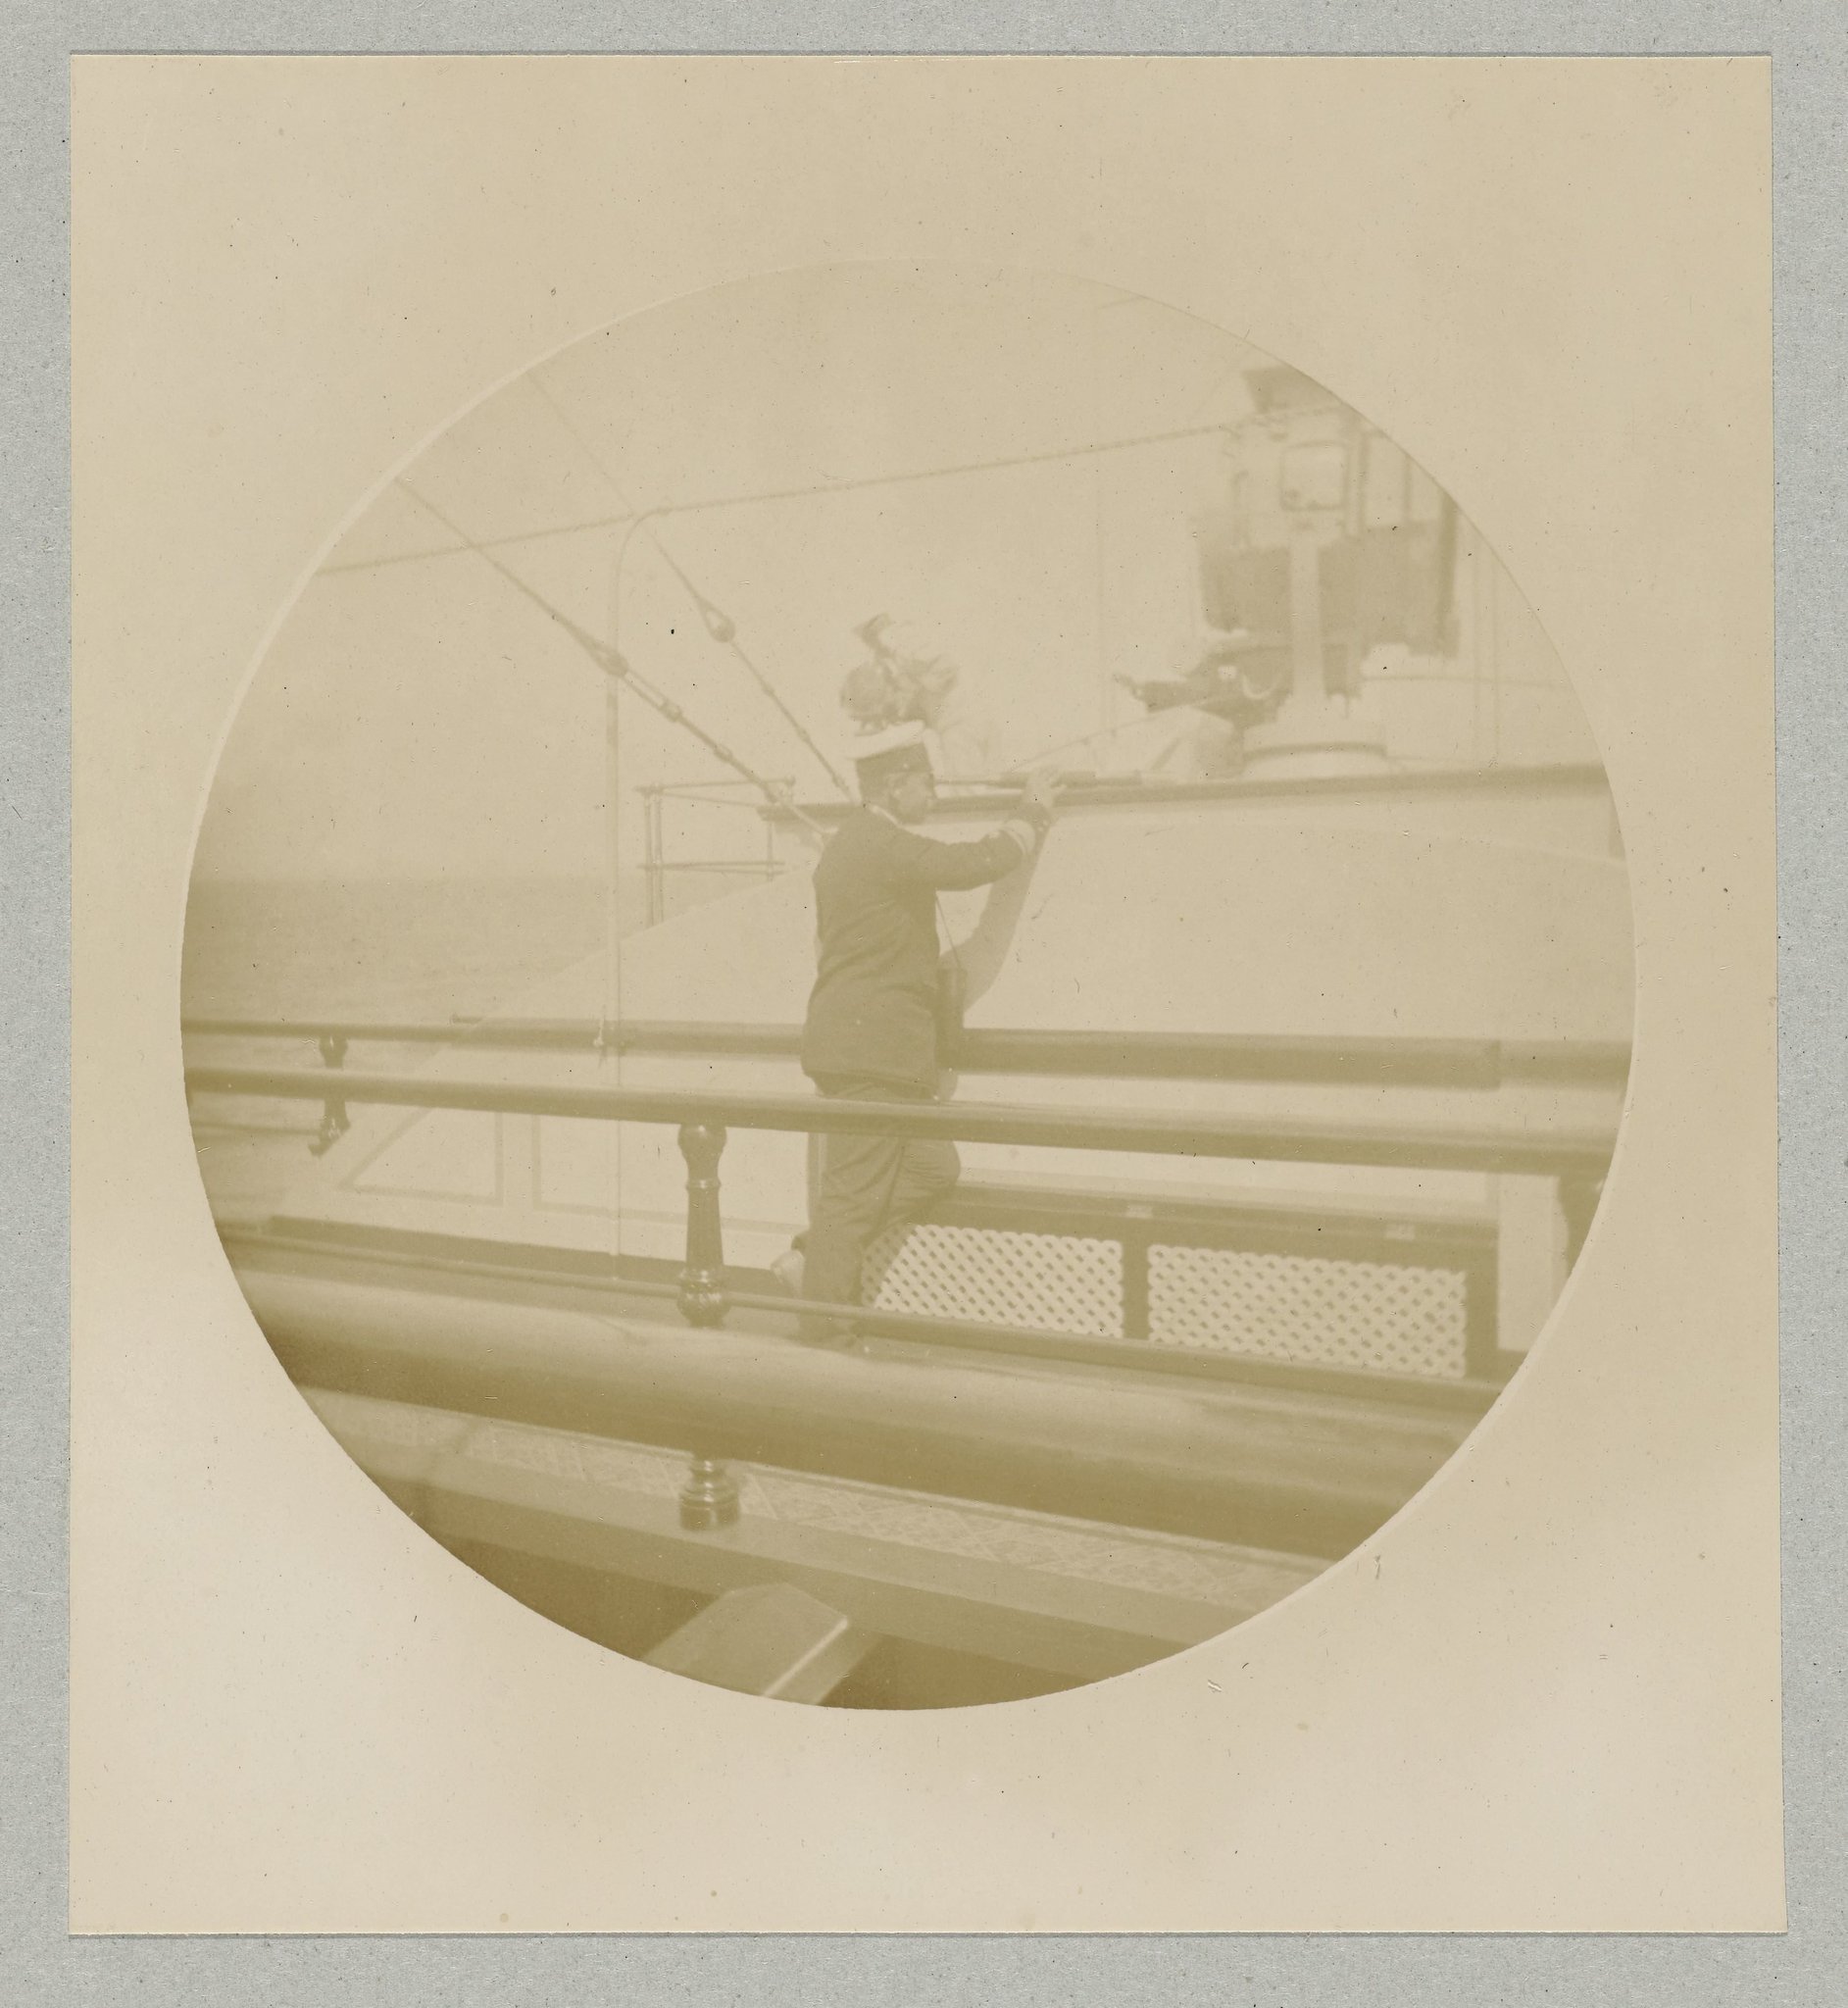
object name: photograph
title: Im Näröfjord bei Gudwangen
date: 1807-1889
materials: cardboard, paper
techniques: gelatin silver print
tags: wilhelm ii (keizer van duitsland), norway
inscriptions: number: ‘15’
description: De afdruk van de foto is rond, het papier vierkant. foto gemaakt met Nr. 1 Kodak Camera